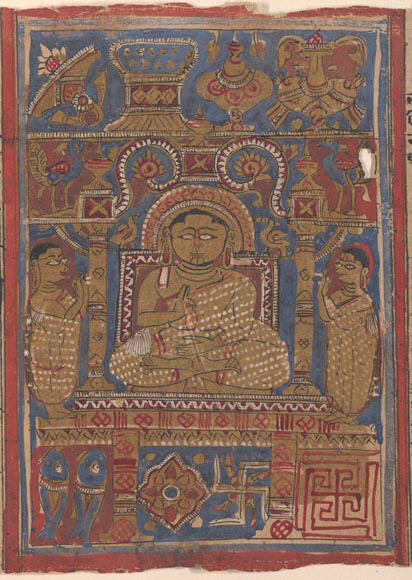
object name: folio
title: A Tirthankara and the Eight Auspicious Symbols; Page from a Dispersed Kalpa Sutra (Jain Book of Rituals)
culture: indian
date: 1401-1500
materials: gold, ink, paper, watercolor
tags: women